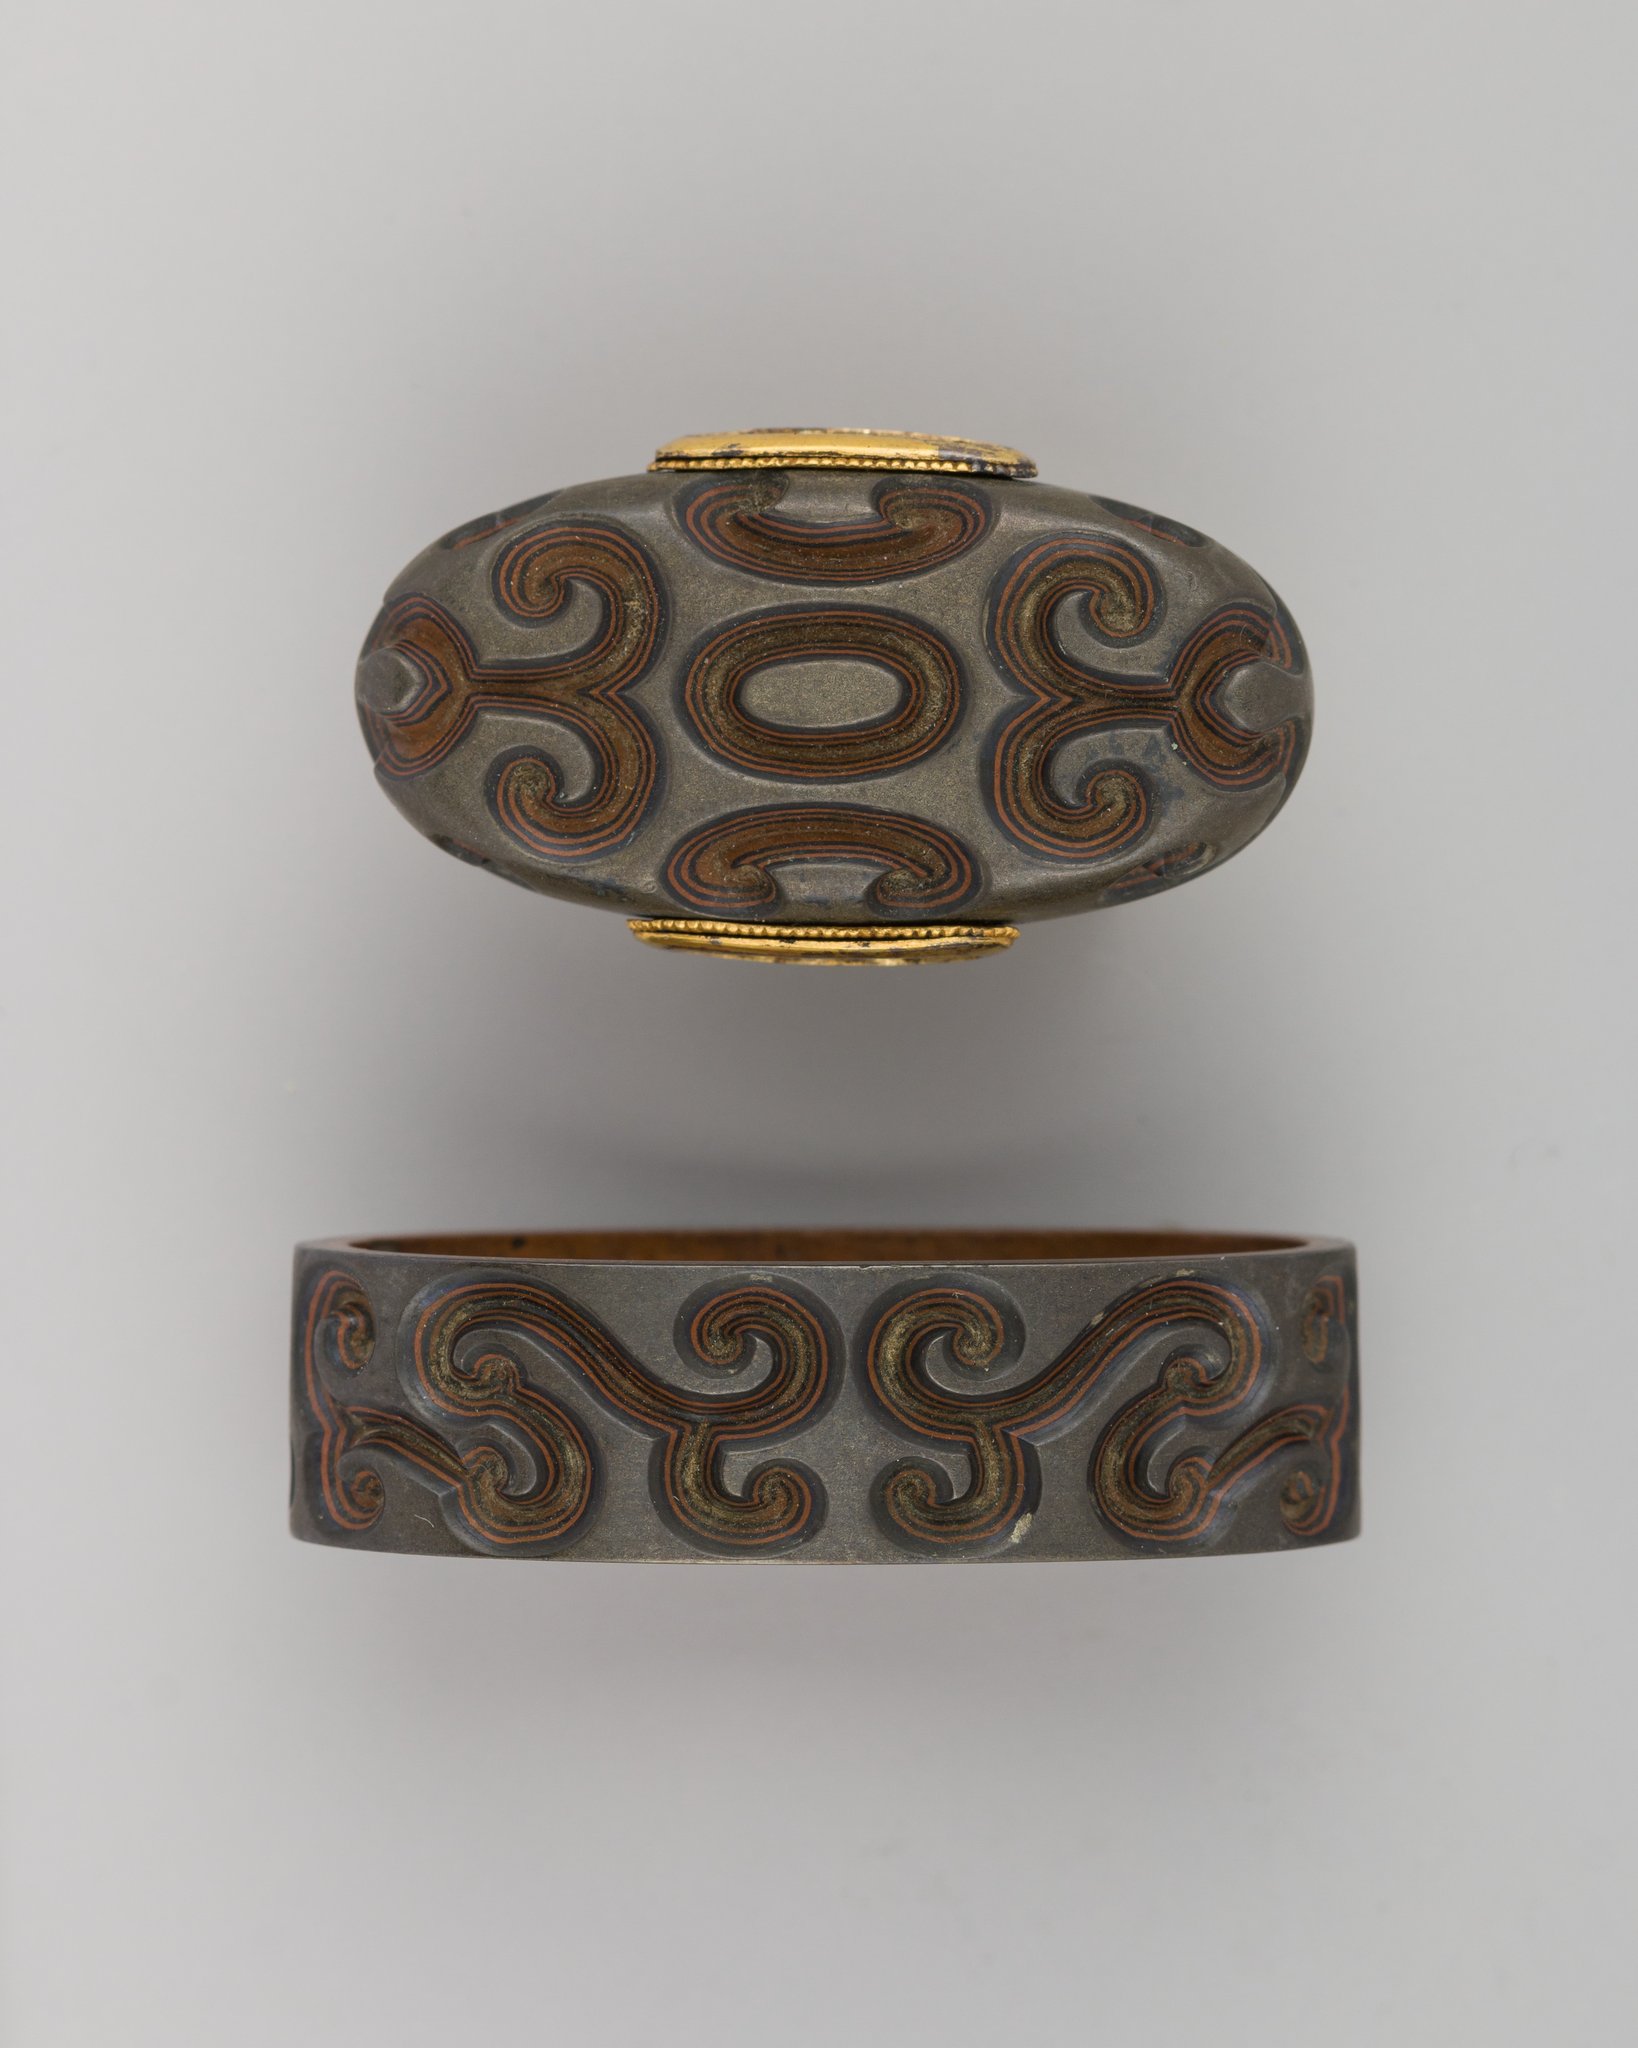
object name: sword hilt collar and pommel fuchigashira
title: Sword-Hilt Collar and Pommel (Fuchigashira)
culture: japanese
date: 1701-1800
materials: copper, silver alloy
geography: japan